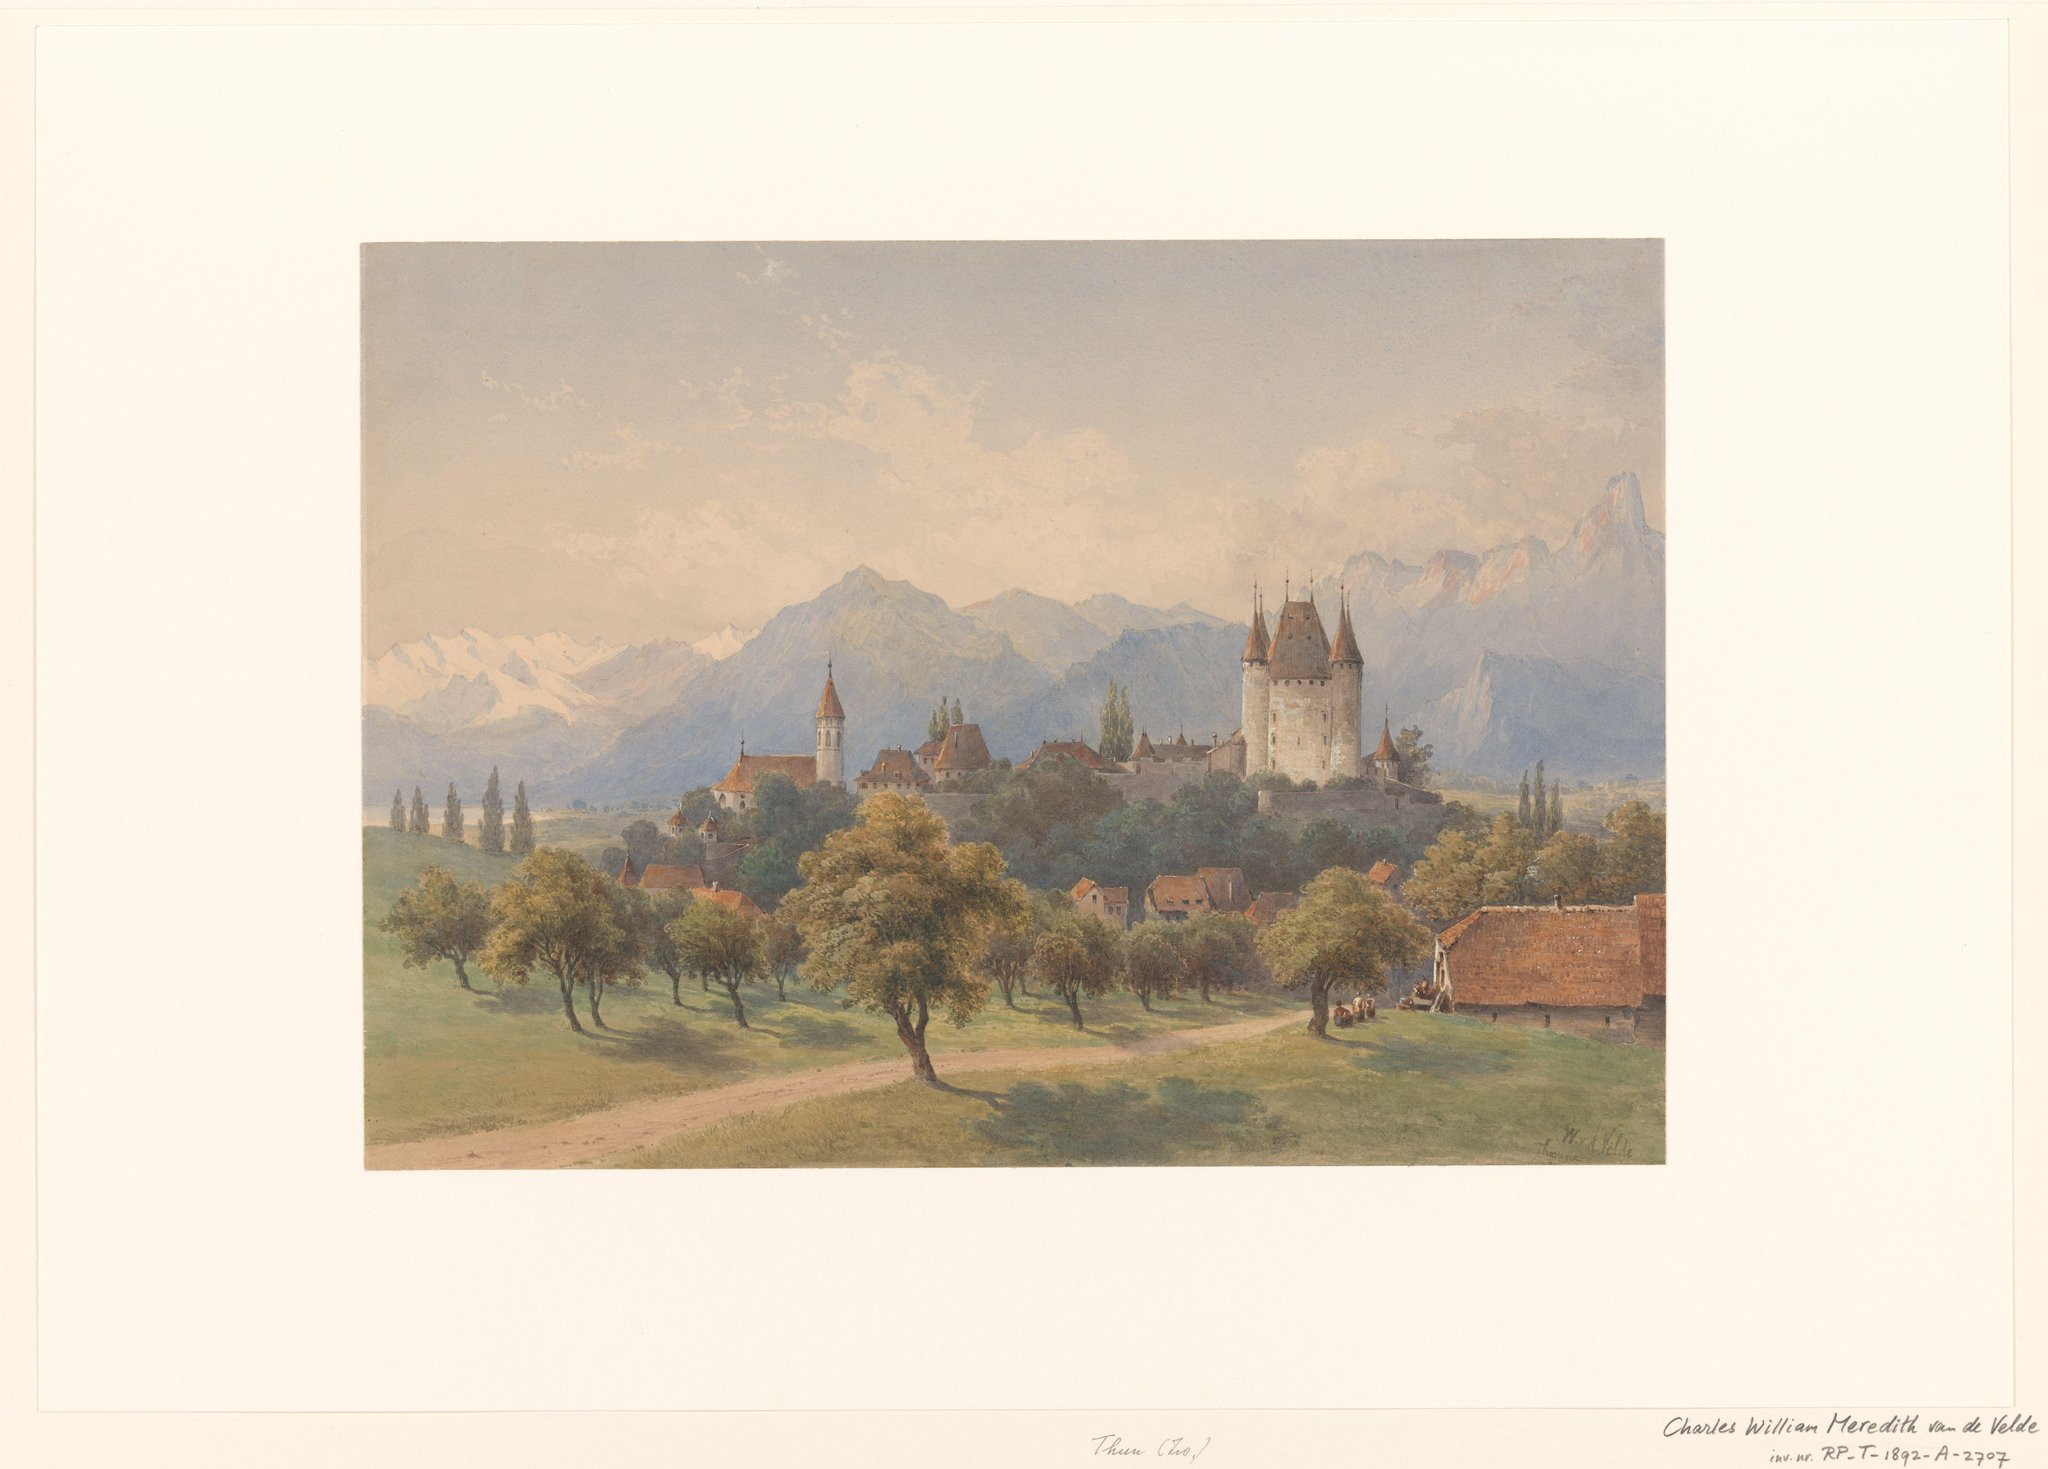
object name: watercolor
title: Gezicht op Thun, Zwitserland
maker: charles william meredith van de velde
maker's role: draughtsman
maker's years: 1818-1898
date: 1828-1892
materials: paper, pencil, watercolor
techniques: brush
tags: prospect of city, town panorama, silhouette of city, mountains, switzerland